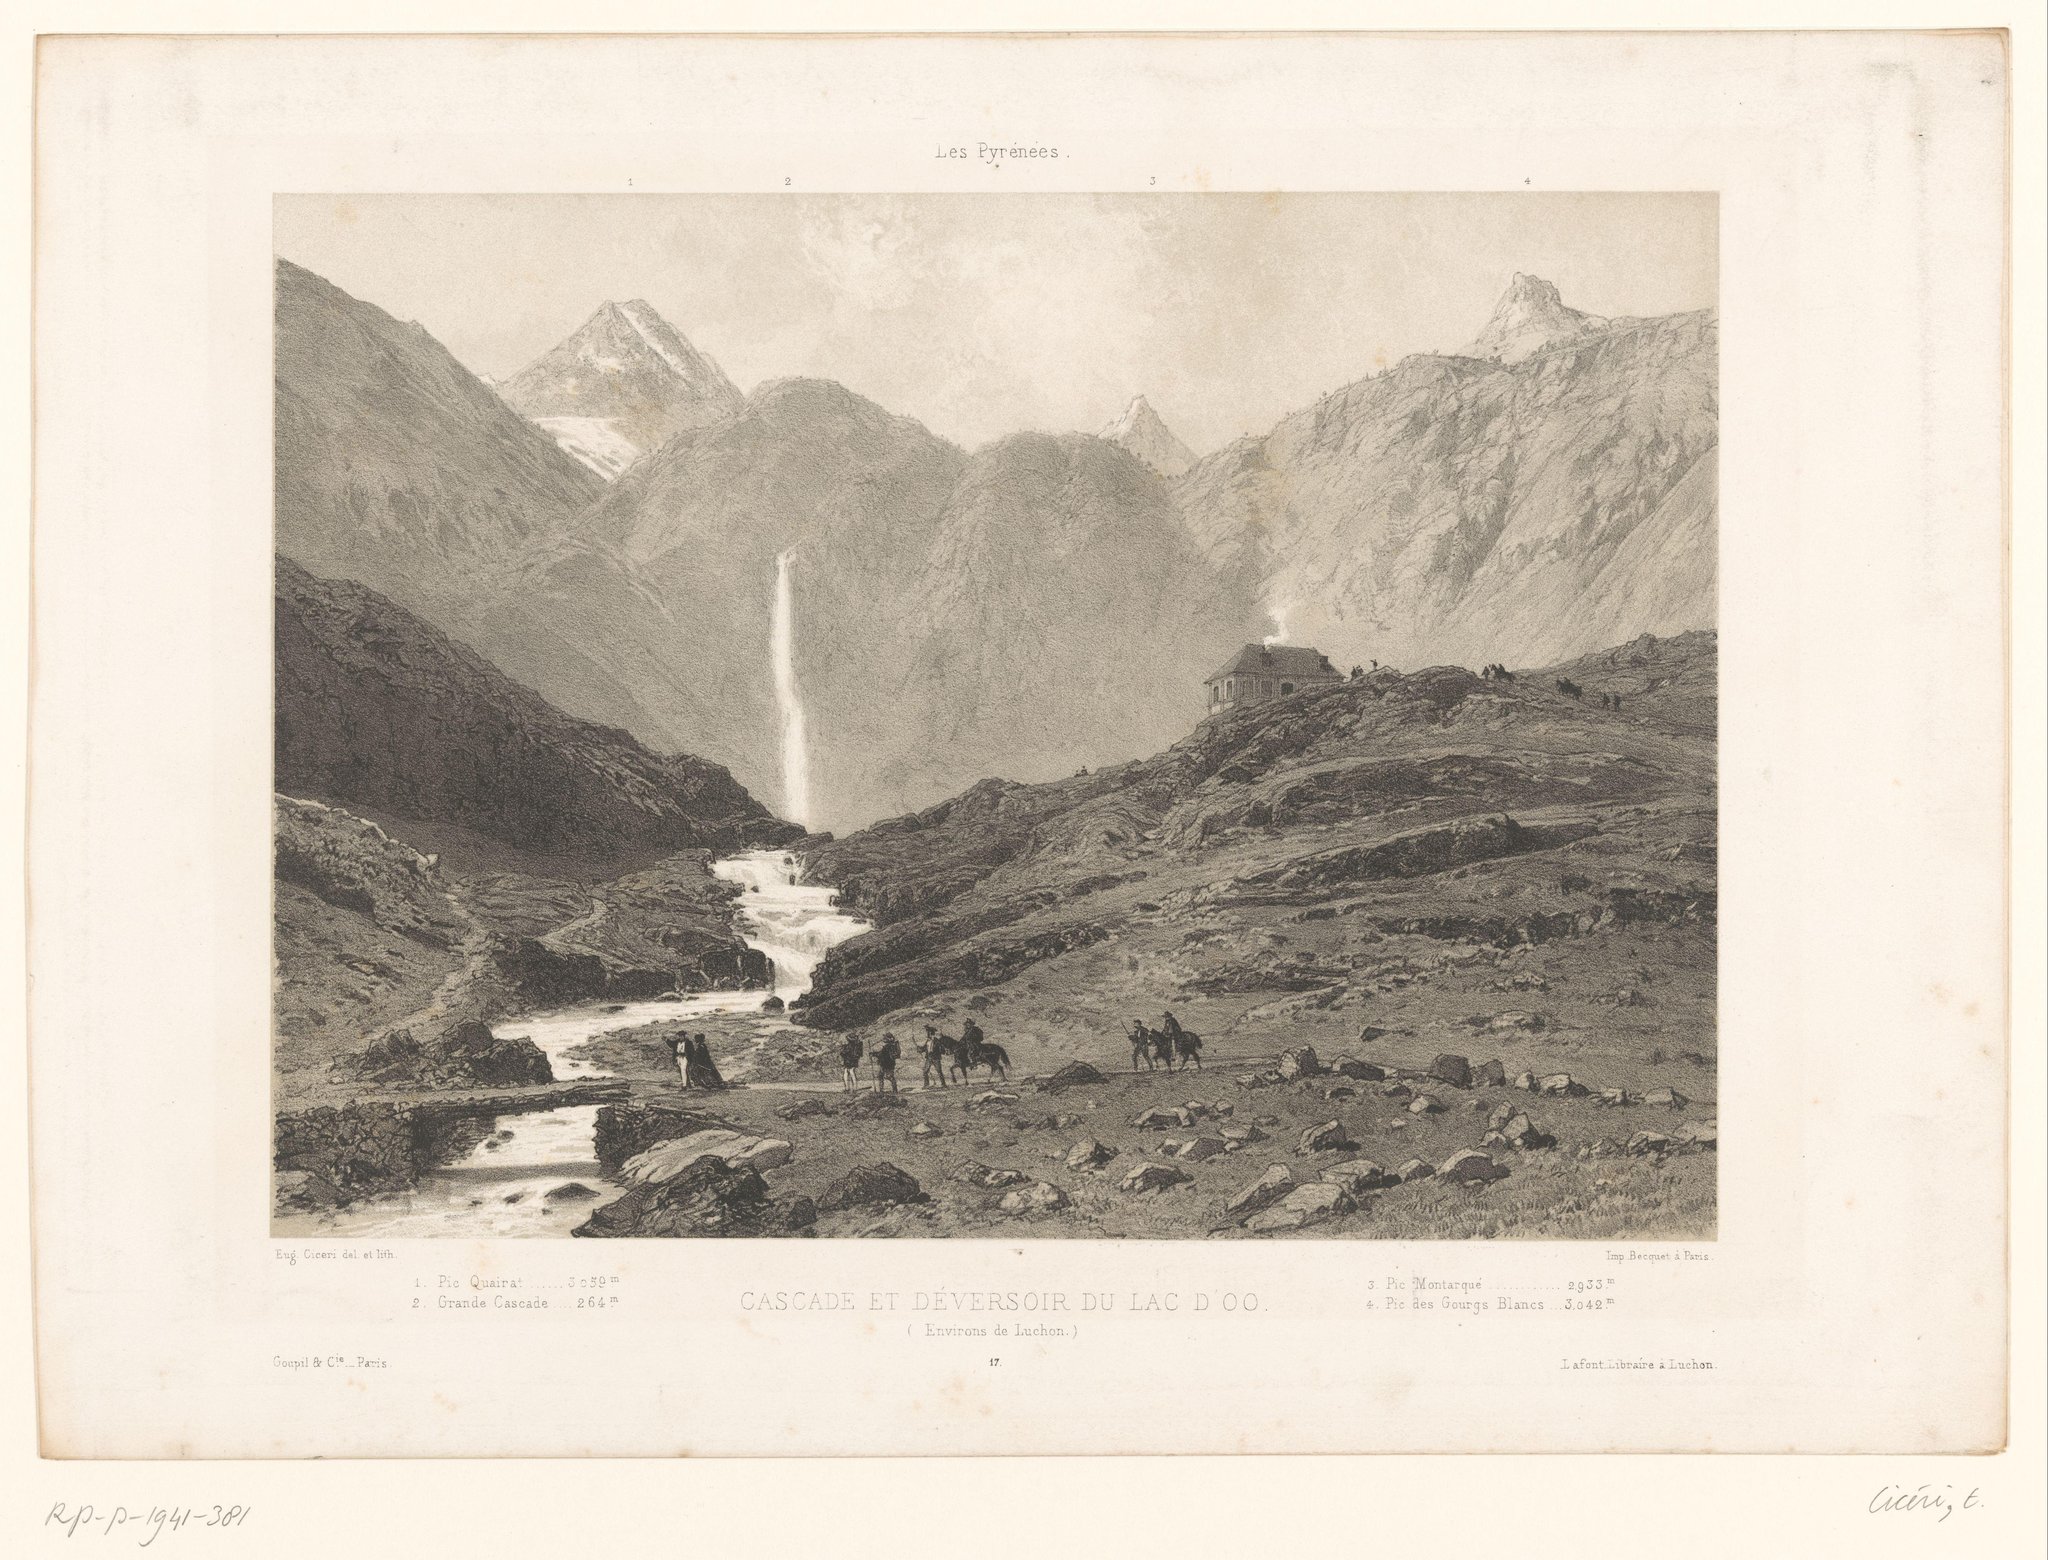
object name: print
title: Cascade et déversoir du Lac d'Oo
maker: eugène cicéri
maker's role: print maker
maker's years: 1813-1890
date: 1858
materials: paper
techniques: tone lithography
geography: paris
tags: waterfall, brook, mountains (+ landscape with figures, staffage)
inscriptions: collector's mark: Lugt 2228a, collector's mark: Lugt 2760